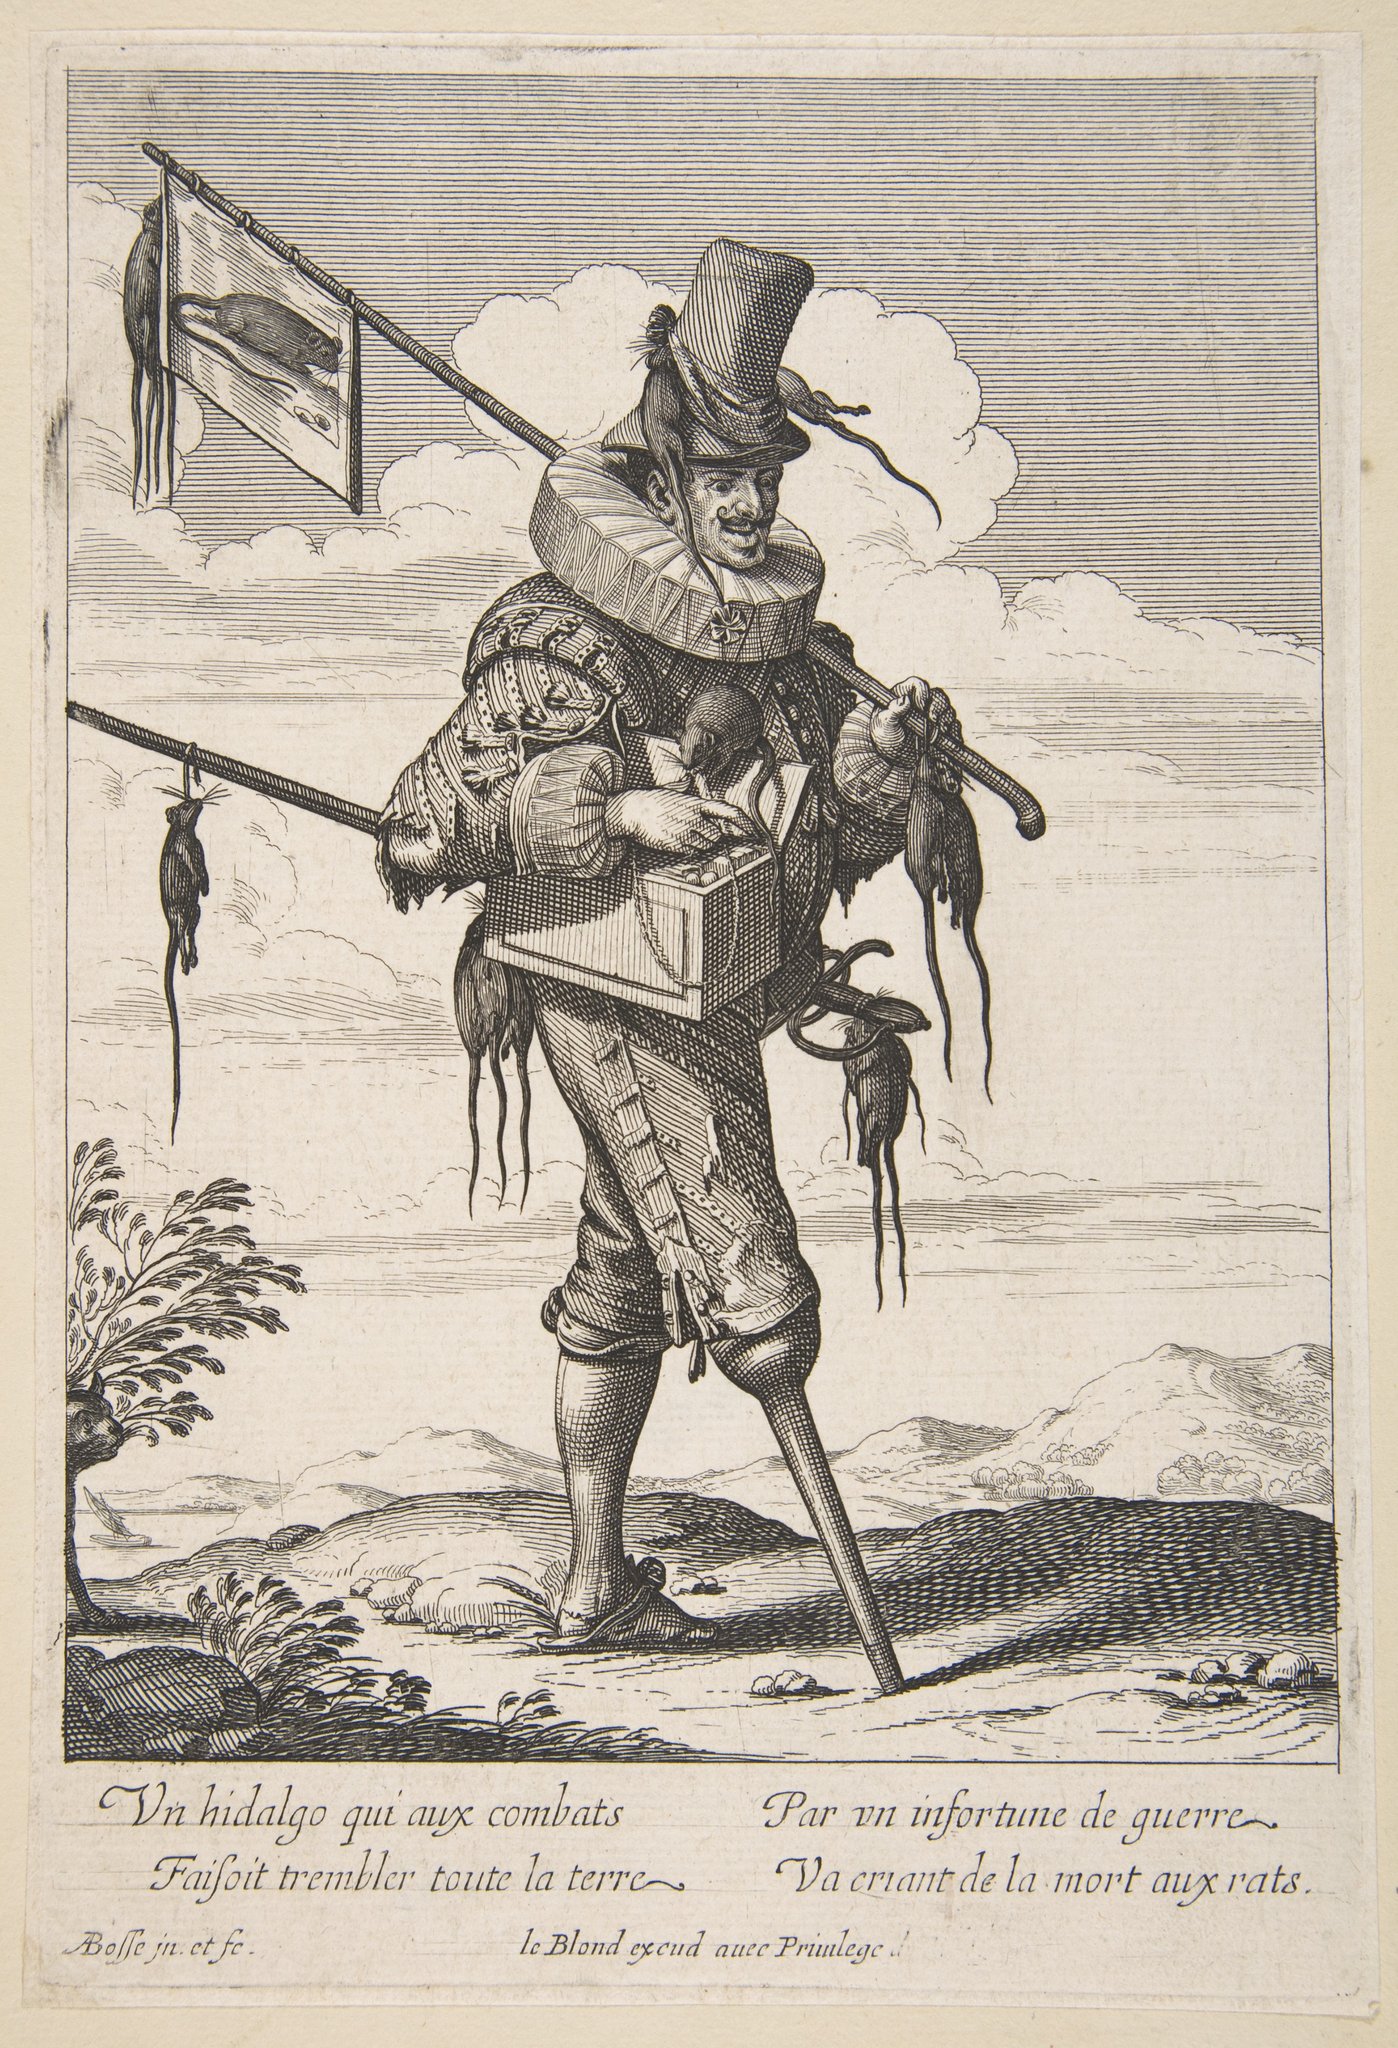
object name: print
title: The Ratcatcher, plate 7 from "Cries of Paris" (Les Cris de Paris)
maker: abraham bosse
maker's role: artist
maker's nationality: french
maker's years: 1602-1676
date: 1632-1633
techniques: etching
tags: hats,men,mice,flags